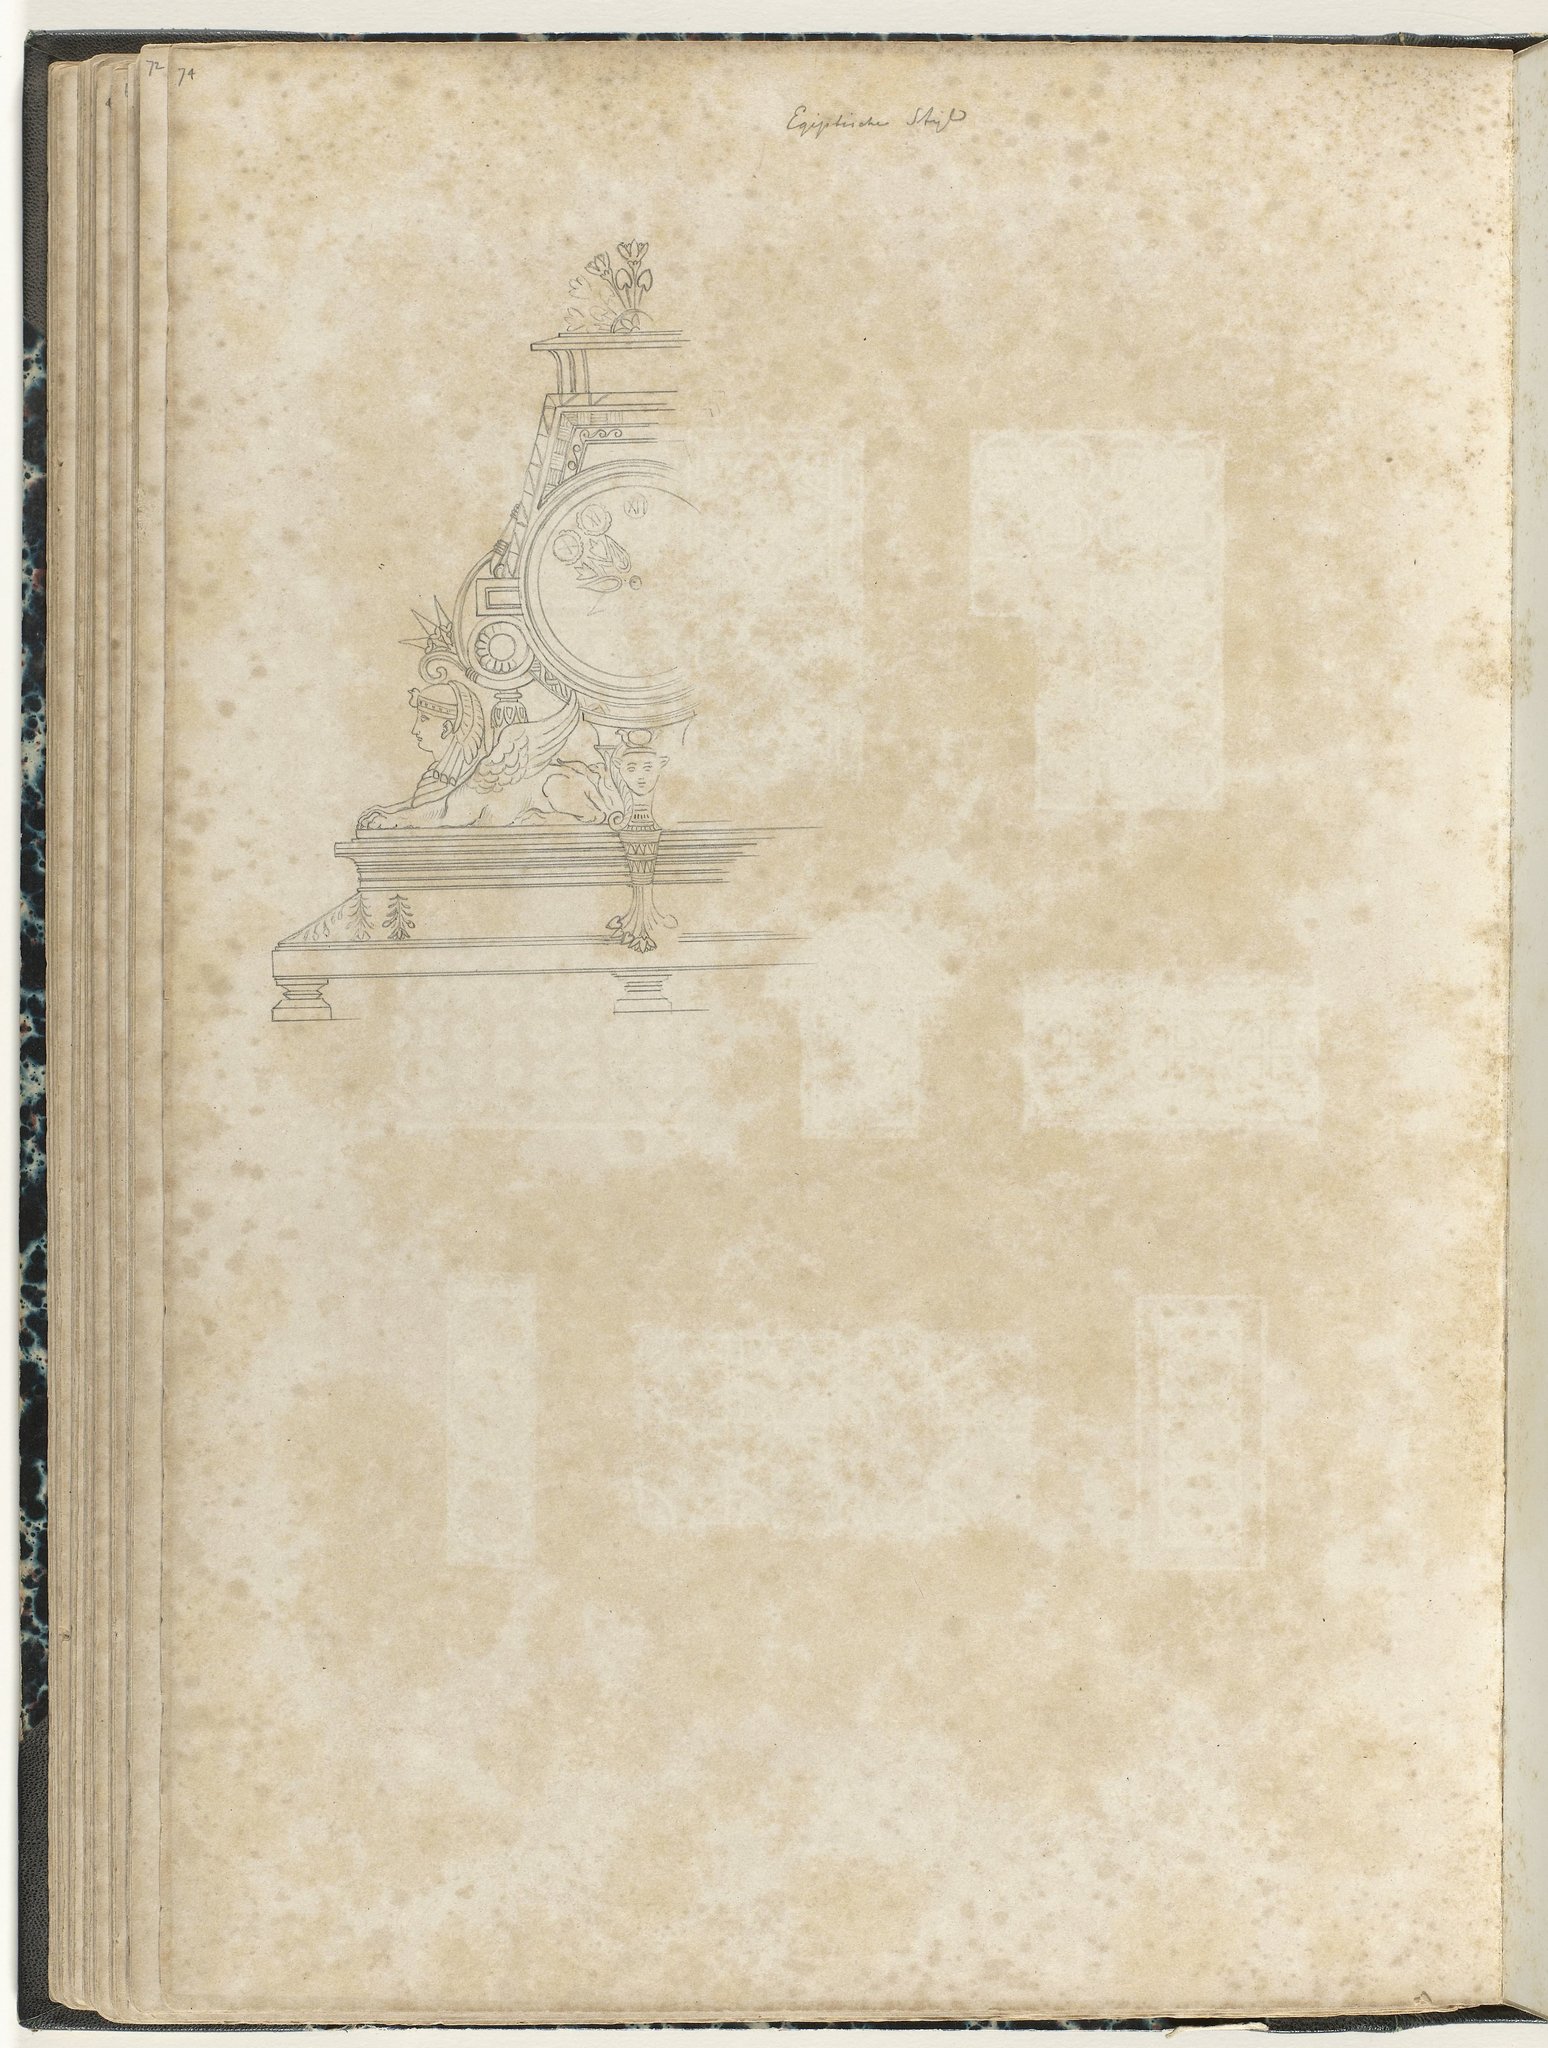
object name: drawing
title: Egyptische Stijl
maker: Anonymous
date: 1866-1900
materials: paper, pencil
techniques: drawing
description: Klok in Egyptische stijl, voor de helft afgebeeld. Links onderaan ligt een sfinx.